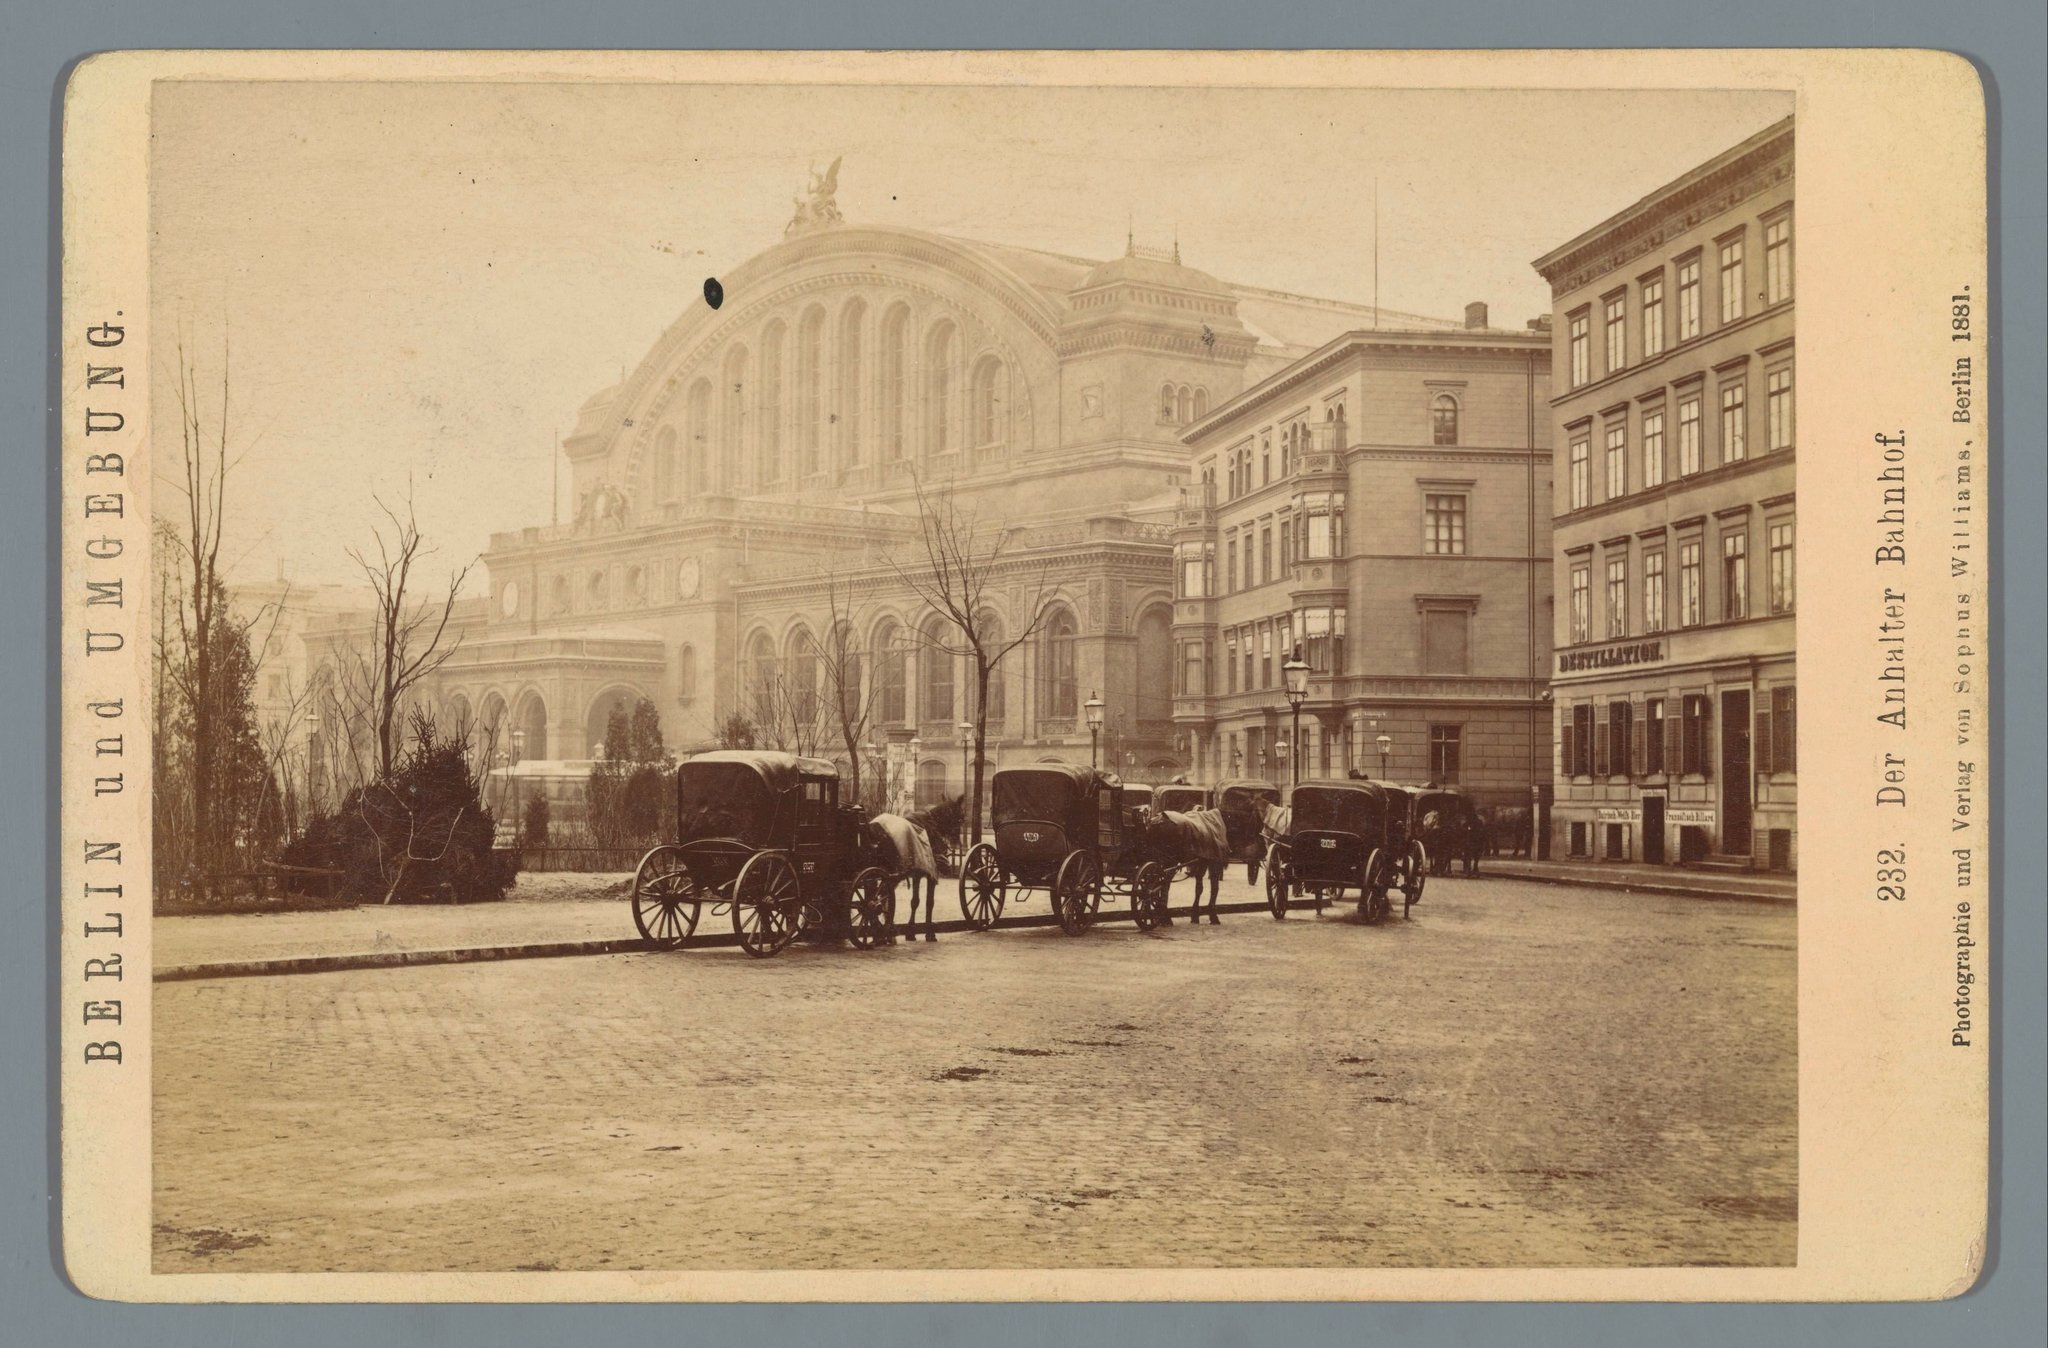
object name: cabinet photograph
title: Gezicht op het Anhalter Bahnhof te Berlijn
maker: sophus williams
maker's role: publisher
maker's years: 1835-1900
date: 1881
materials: cardboard, photographic support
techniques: albumen print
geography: berlin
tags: façade (of house or building), station; shelter (railway, tramway), passenger carriage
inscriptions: initials: ‘[...] B.’, number: ‘232.’, workshop stamp: ‘Photographie und Verlag von SOPHUS WILIAMS, Berlin 1881.’